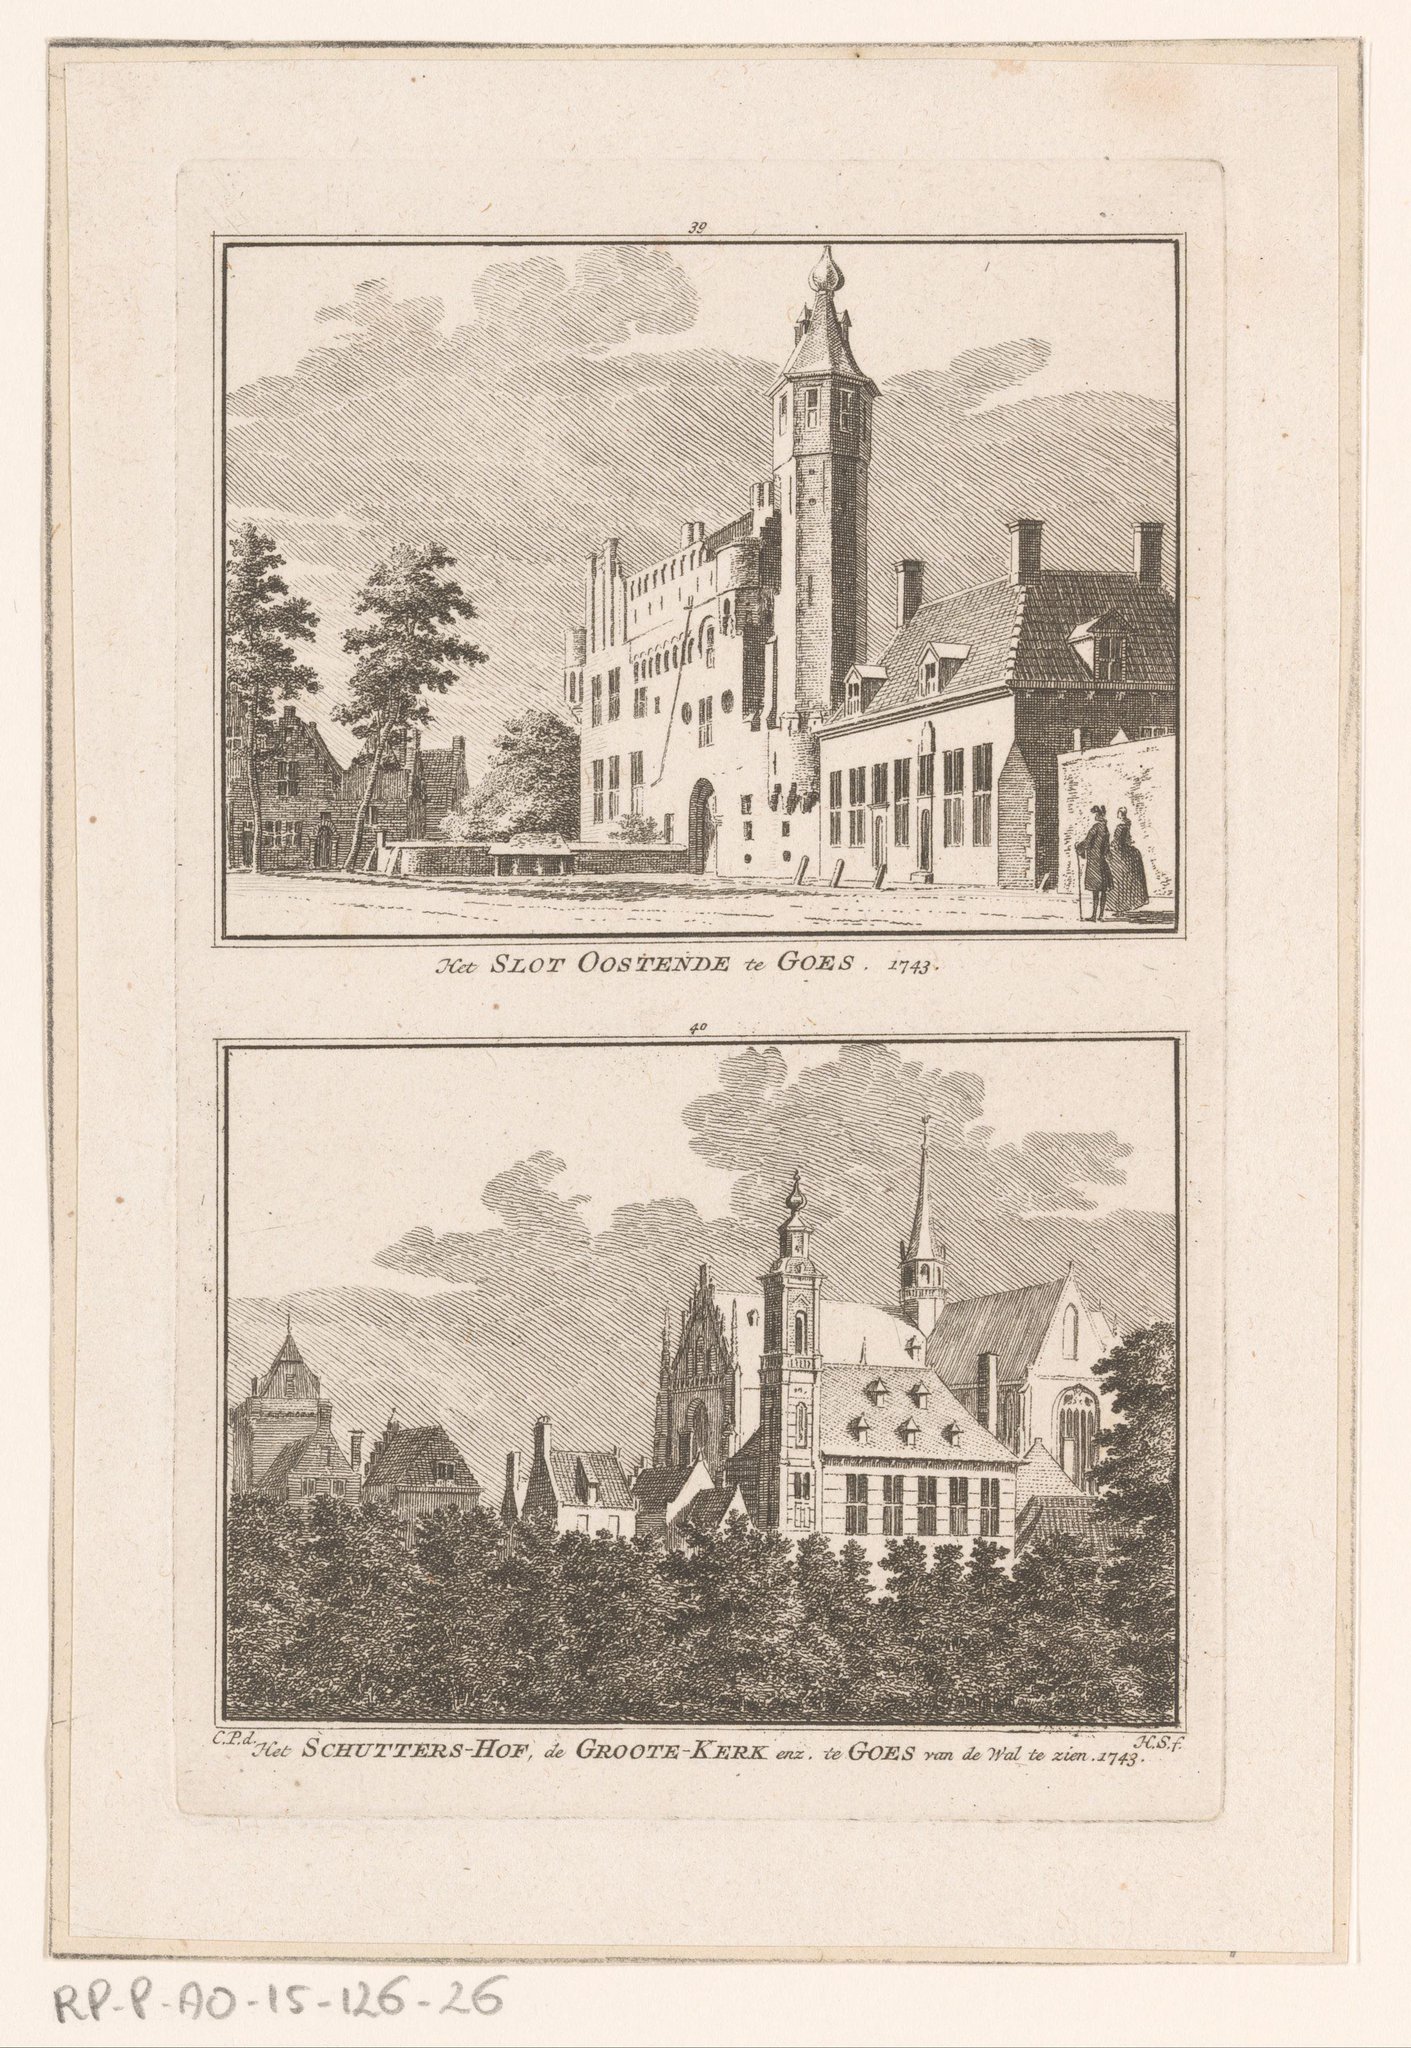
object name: book illustration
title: Gezicht op Slot Ostende en gezicht op het Schuttershof en de Grote Kerk te Goes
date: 1754-1792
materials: paper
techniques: etching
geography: haarlem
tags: castle, church (exterior), slot ostende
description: Prent ook gebruikt in: Het verheerlykt Nederland of kabinet van hedendaagsche gezigten van steden, dorpen (…). 9 delen. Amsterdam: Isaak Tirion en weduwe Isaak Tirion, 1745-1774, dl. 5 (1754), ill. 39-40. Of in: Nederlandsche tafereelen; of eene keurige verzameling van negen honderd fraaije gezigten van steden, dorpen, sloten, oudheden [….]. 9 delen. Amsterdam: Jan de Groot, 1792, dl. 5, ill. 39-40.